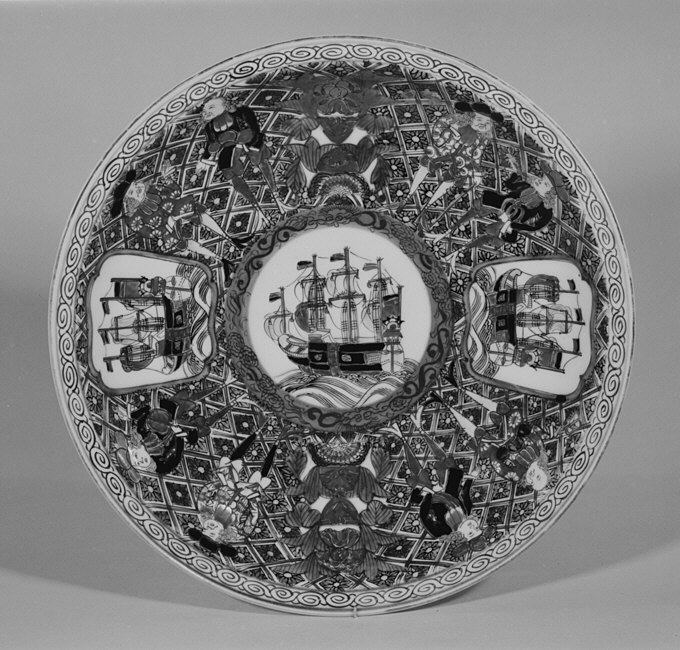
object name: plate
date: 1767-1833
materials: hard paste porcelain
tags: women,flowers,ships